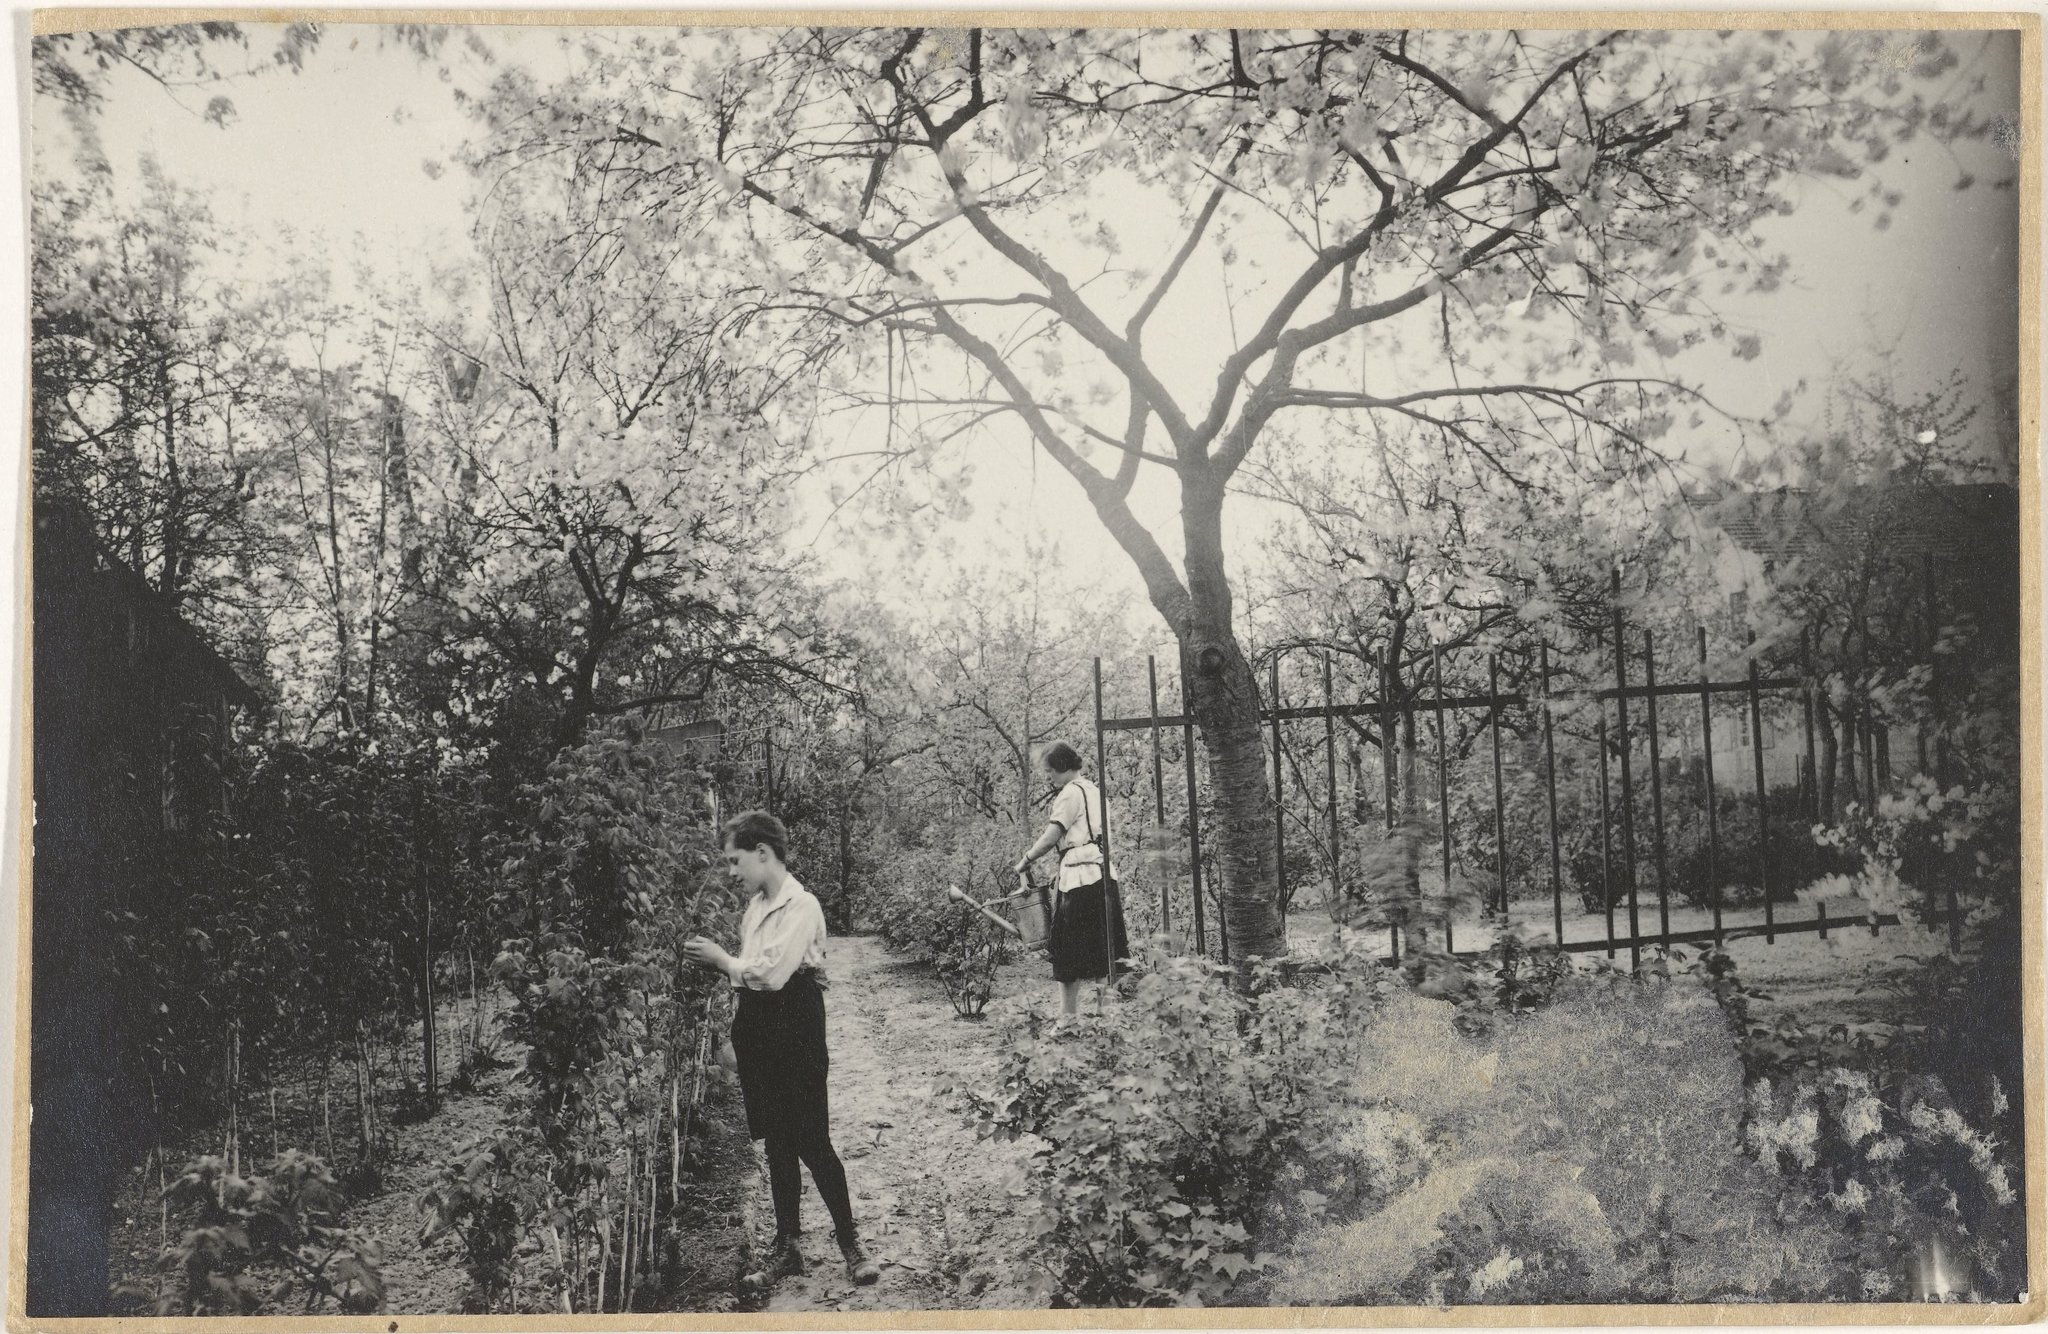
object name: photograph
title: Een vrouw en een jongen in een tuin, Lichterfelde, Berlijn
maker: waldemar titzenthaler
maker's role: fotograaf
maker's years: 1869-1937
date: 1925-1930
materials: paper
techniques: gelatin silver print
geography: lichterfelde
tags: berlin, engineer, gardening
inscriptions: inscription: ‘Lichterfelde Zerbsterstr. 32’